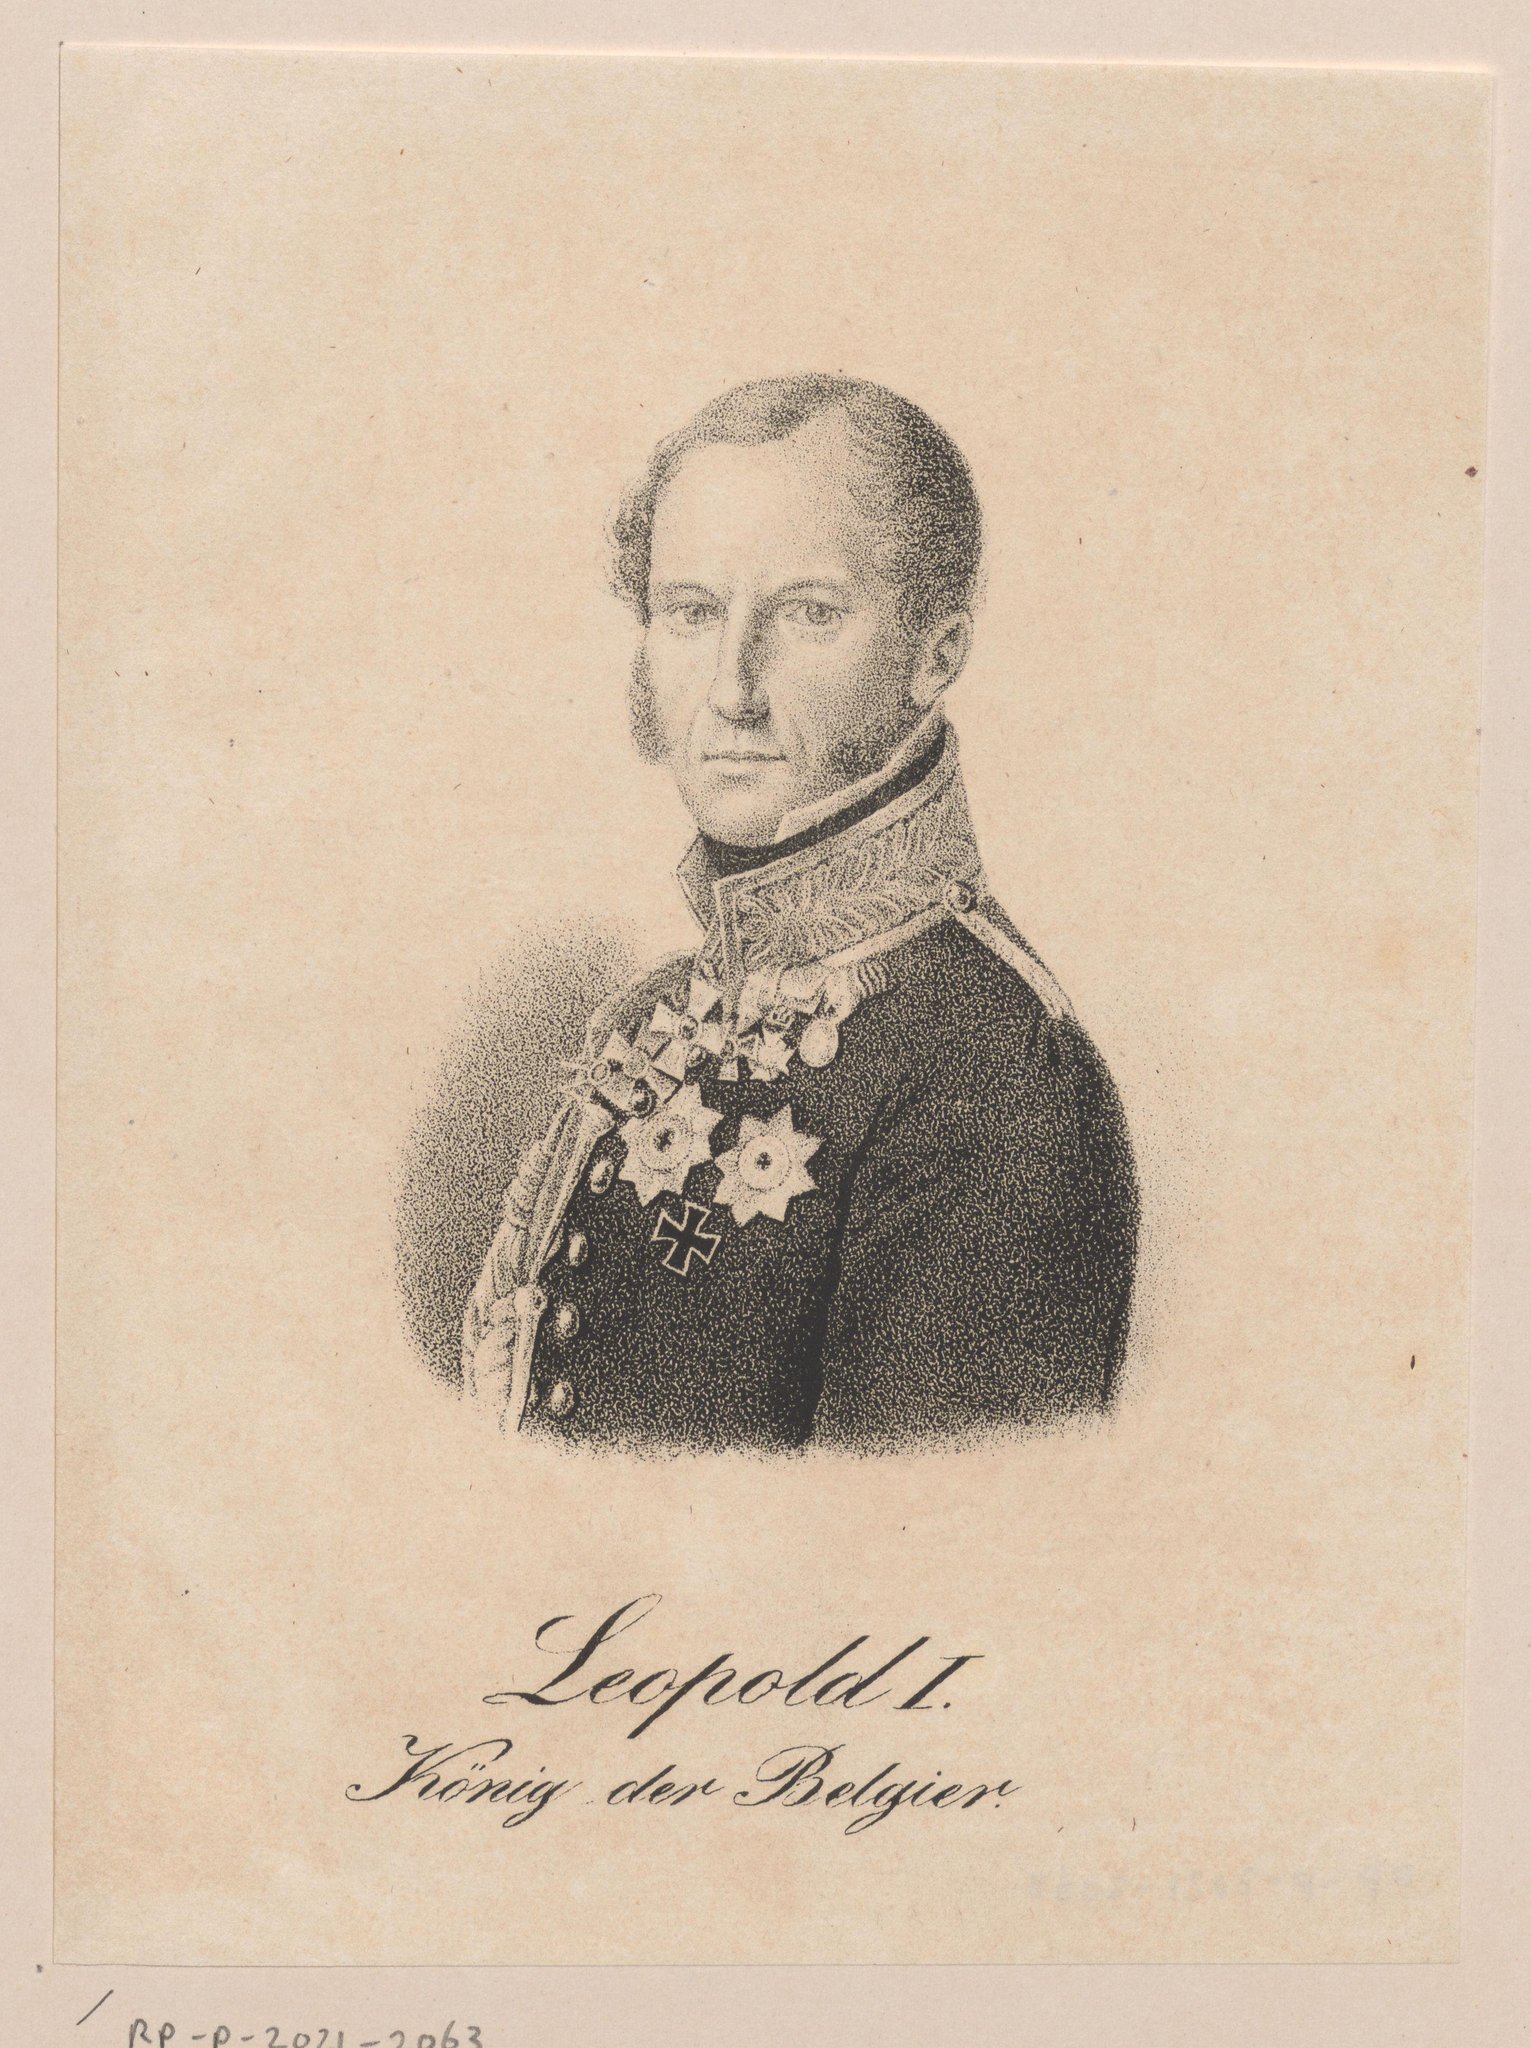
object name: print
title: Portret van Leopold I van België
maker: Anonymous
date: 1831-1865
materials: paper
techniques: lithograph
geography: germany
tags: laeken, leopold i (koning der belgen), knighthood order, historical persons, (military) uniforms, king